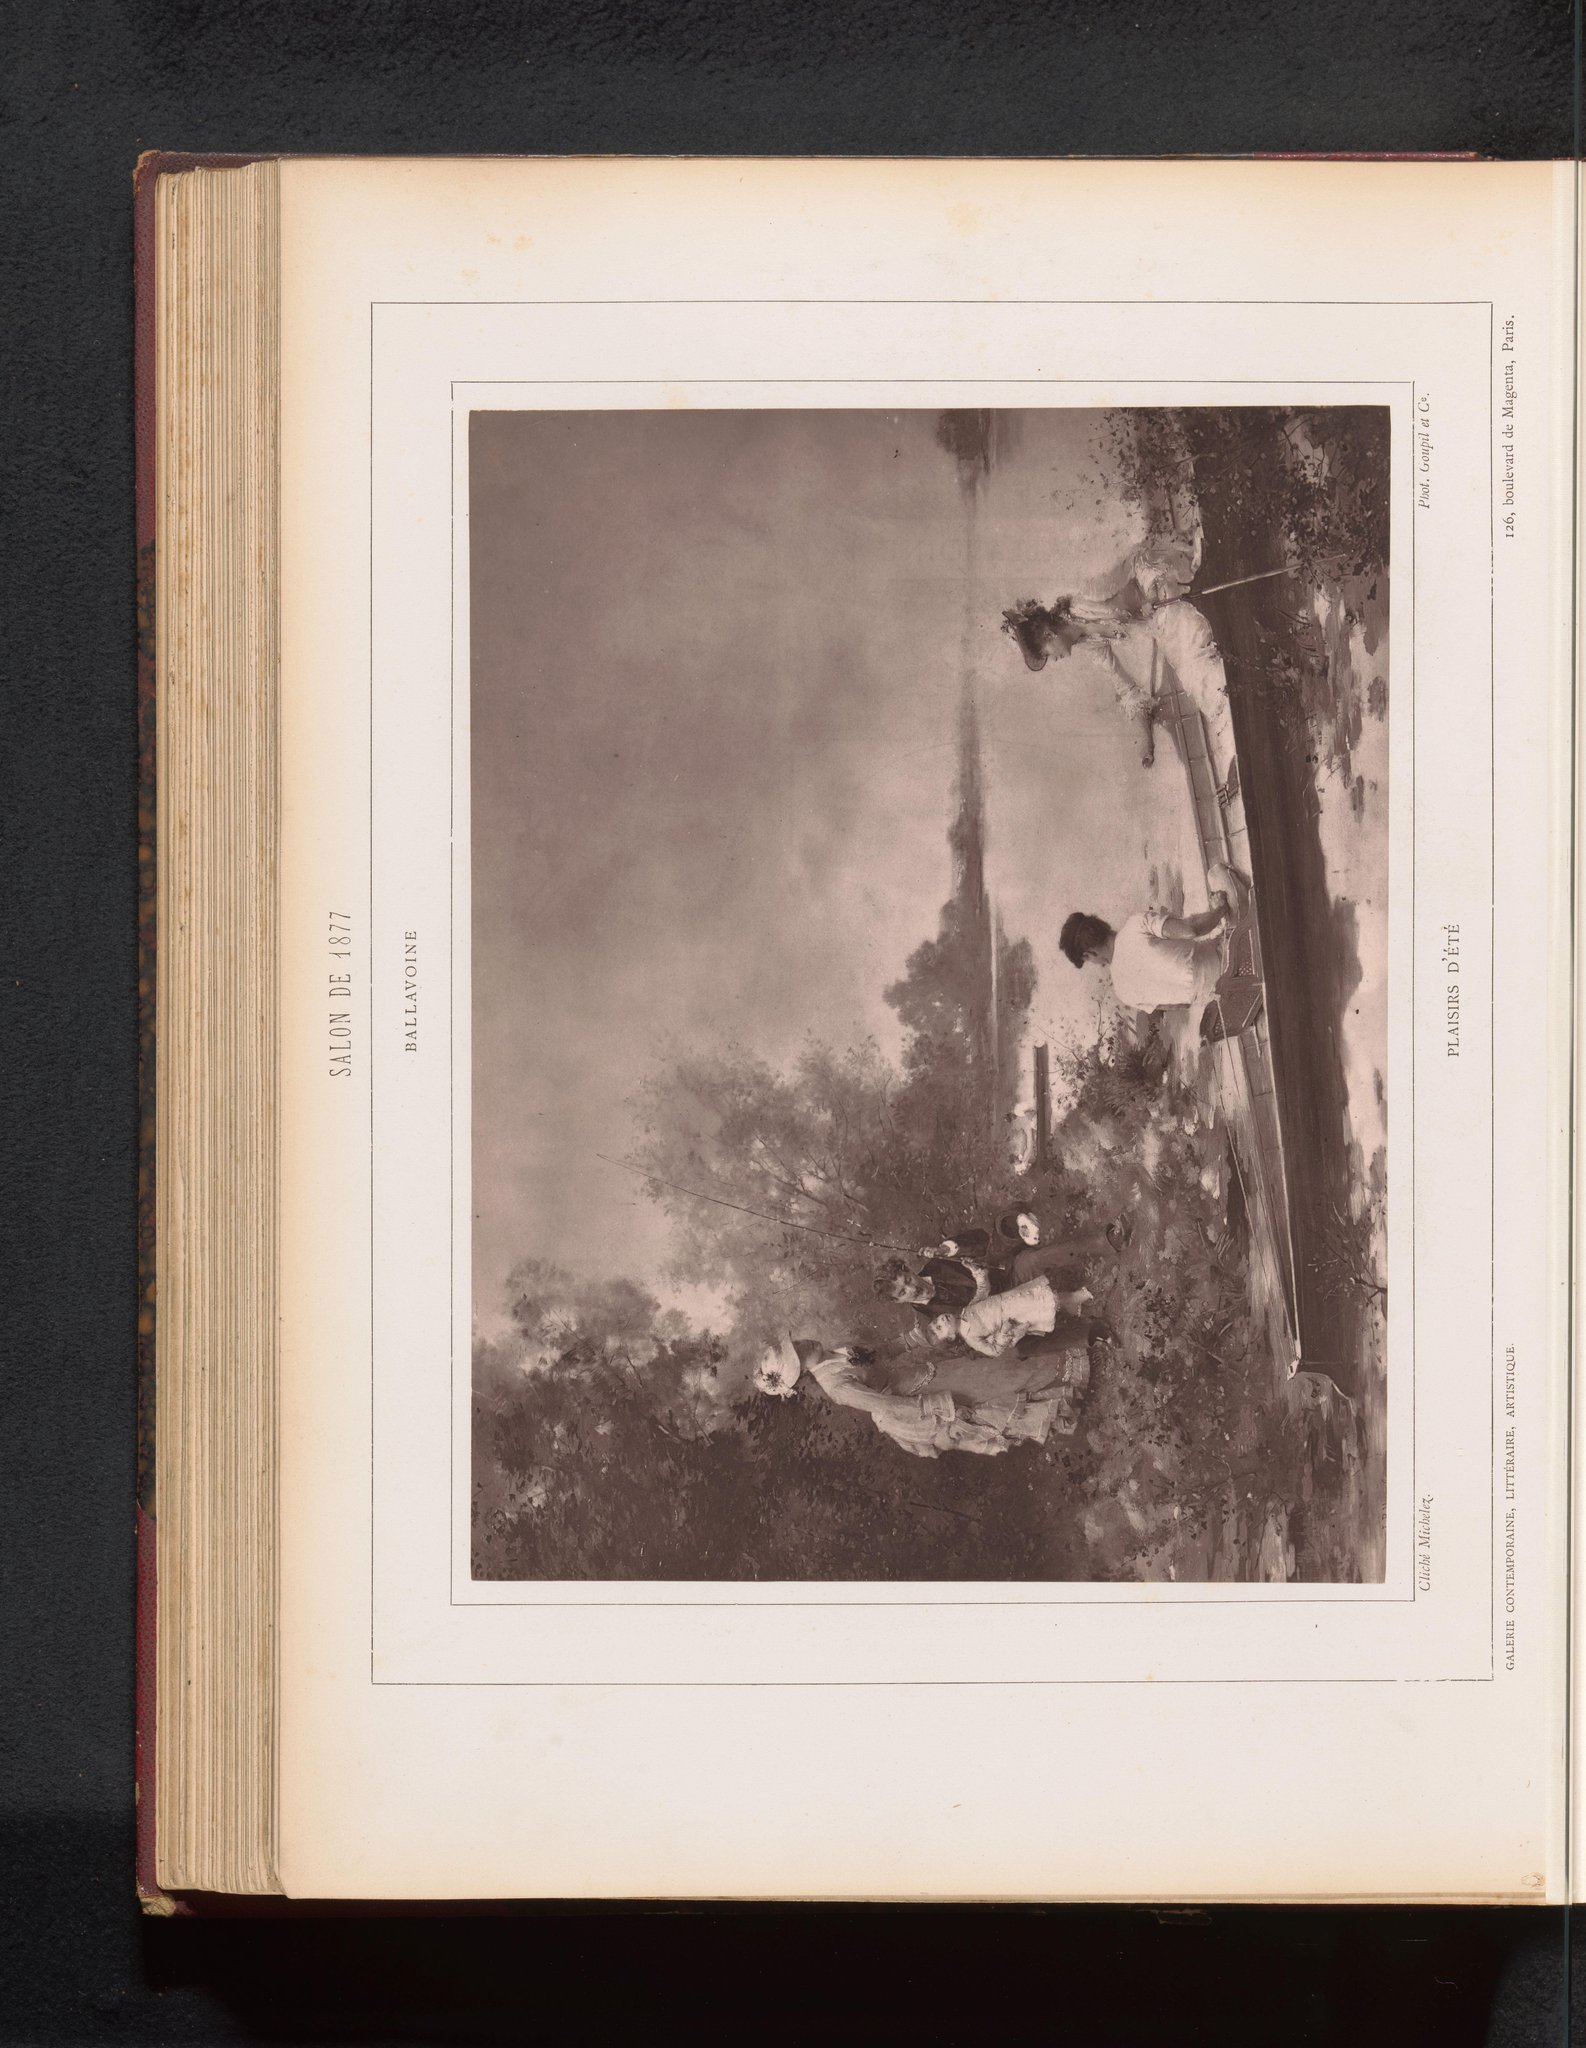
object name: page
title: Reproductie van Plaisirs d'été door Jules-Frédéric Ballavoine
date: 1871-1876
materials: paper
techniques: woodburytype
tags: historical persons, landscapes with waters, waterscapes, seascapes (in the temperate zone), rowing-boat, canoe, etc., painting, drawing and the graphic arts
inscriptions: inscription: ‘Salon de 1877/ Ballavoine/ Galerie Contemporaine, Littéraire et Artistique/ 126, boulevard de Magenta, Paris.’